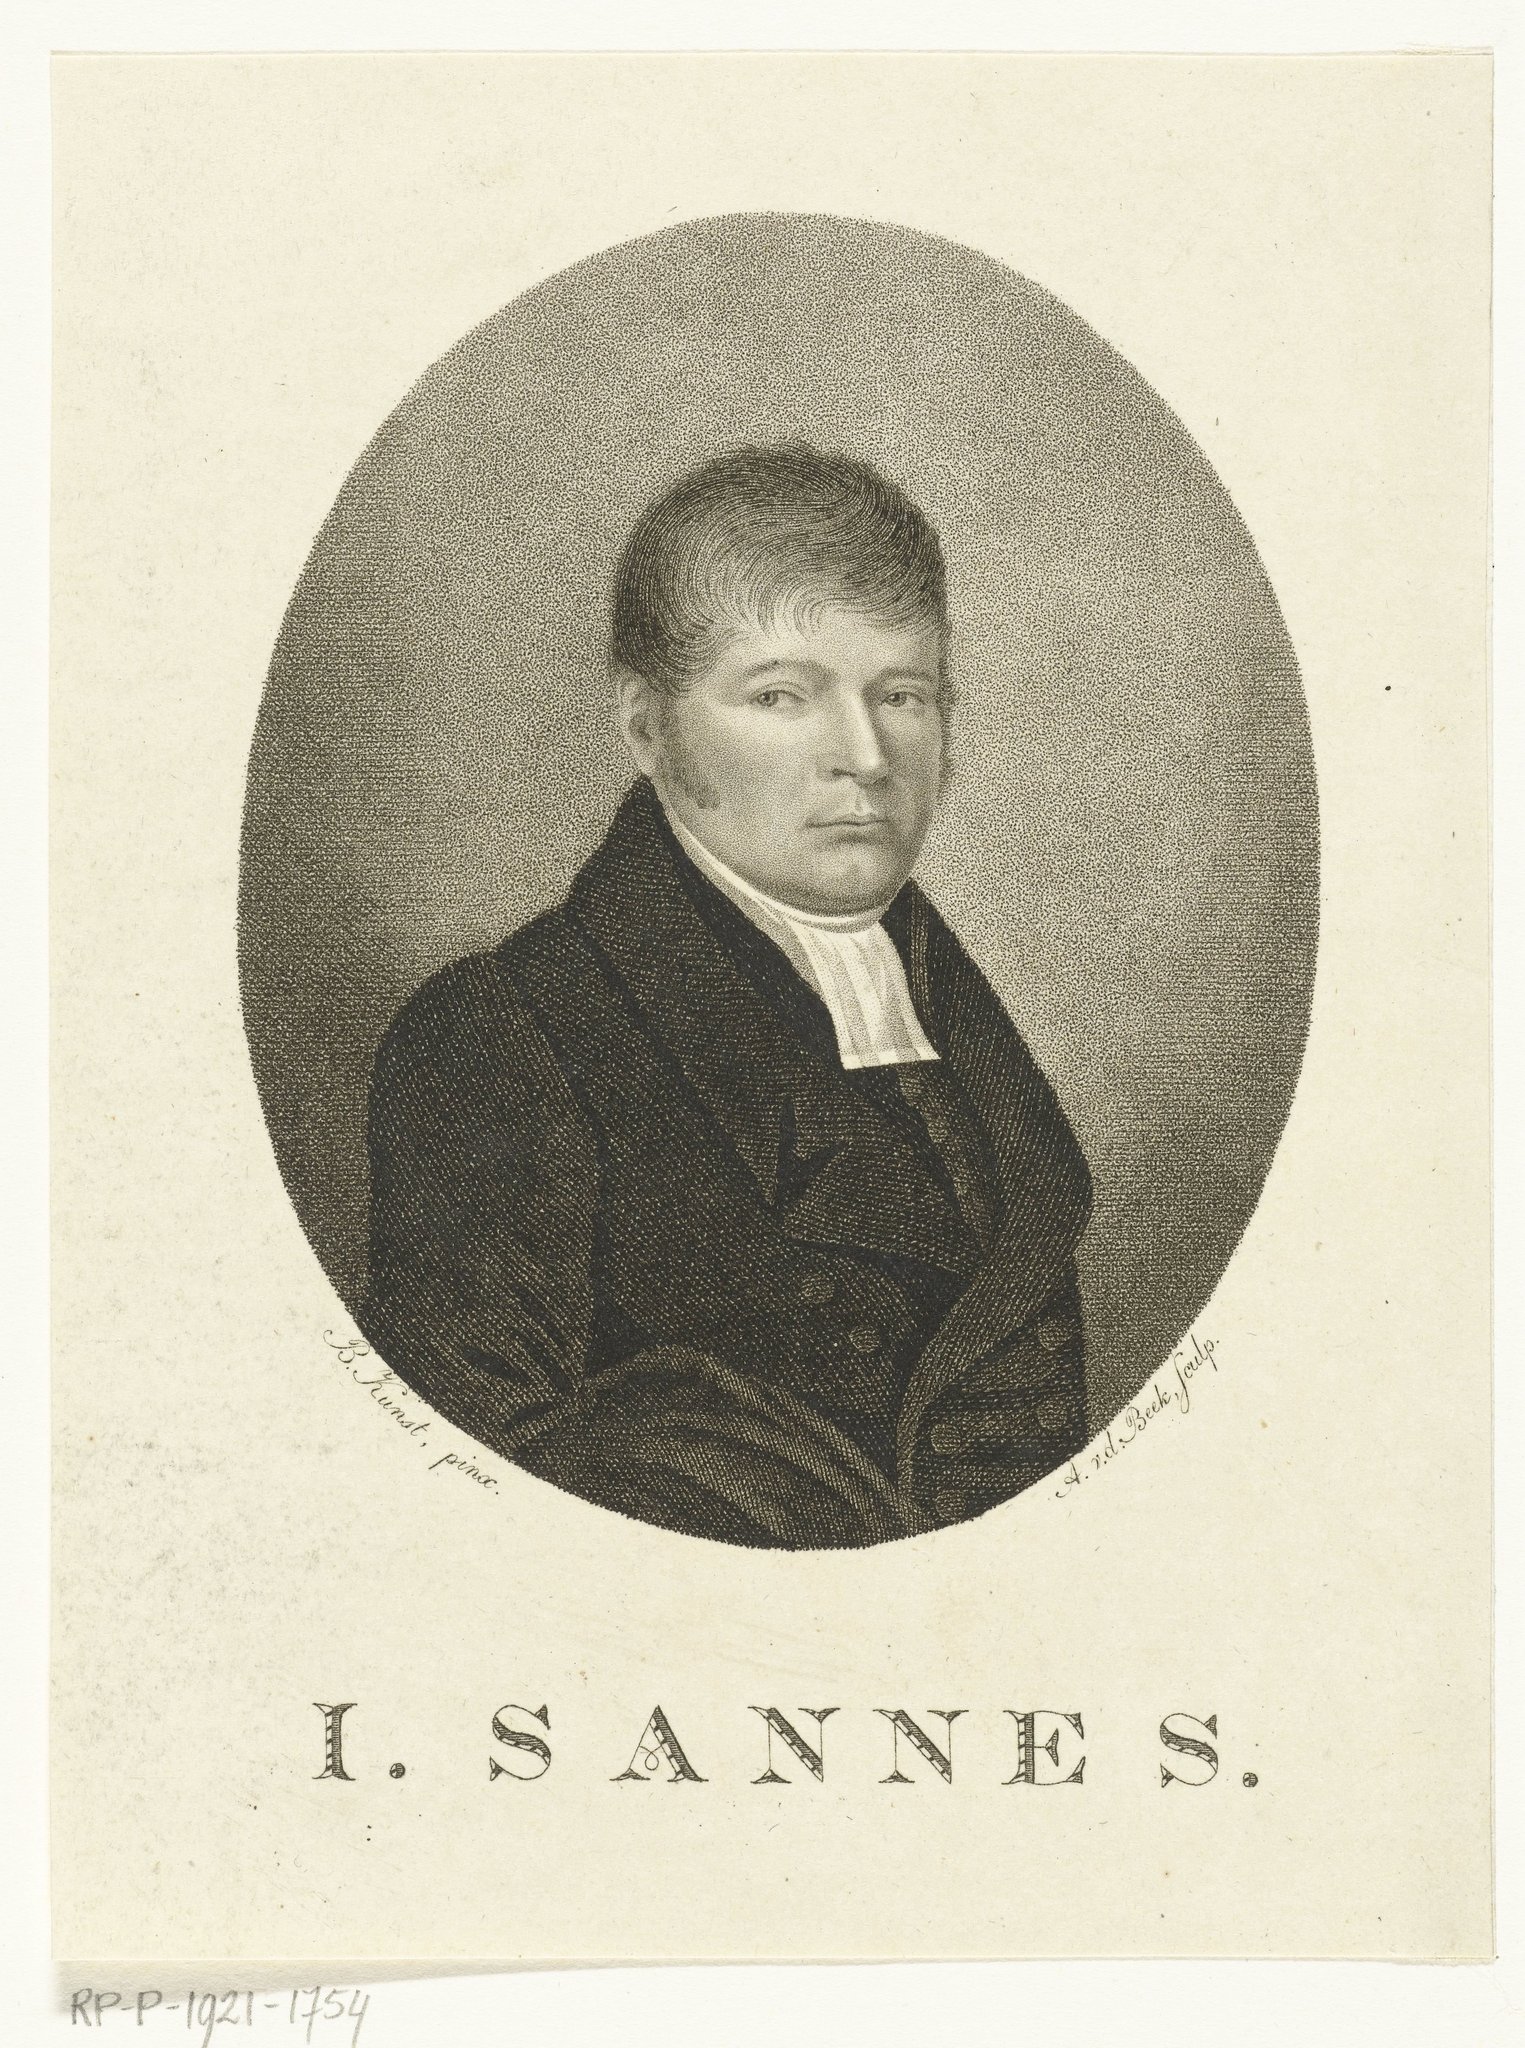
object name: print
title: Portret van predikant Isaäk Sannes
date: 1793-1852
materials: paper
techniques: aquatint, etching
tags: functionaries and dignitaries (with name) ~ episcopal protestant churches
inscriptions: collector's mark: Lugt 2228